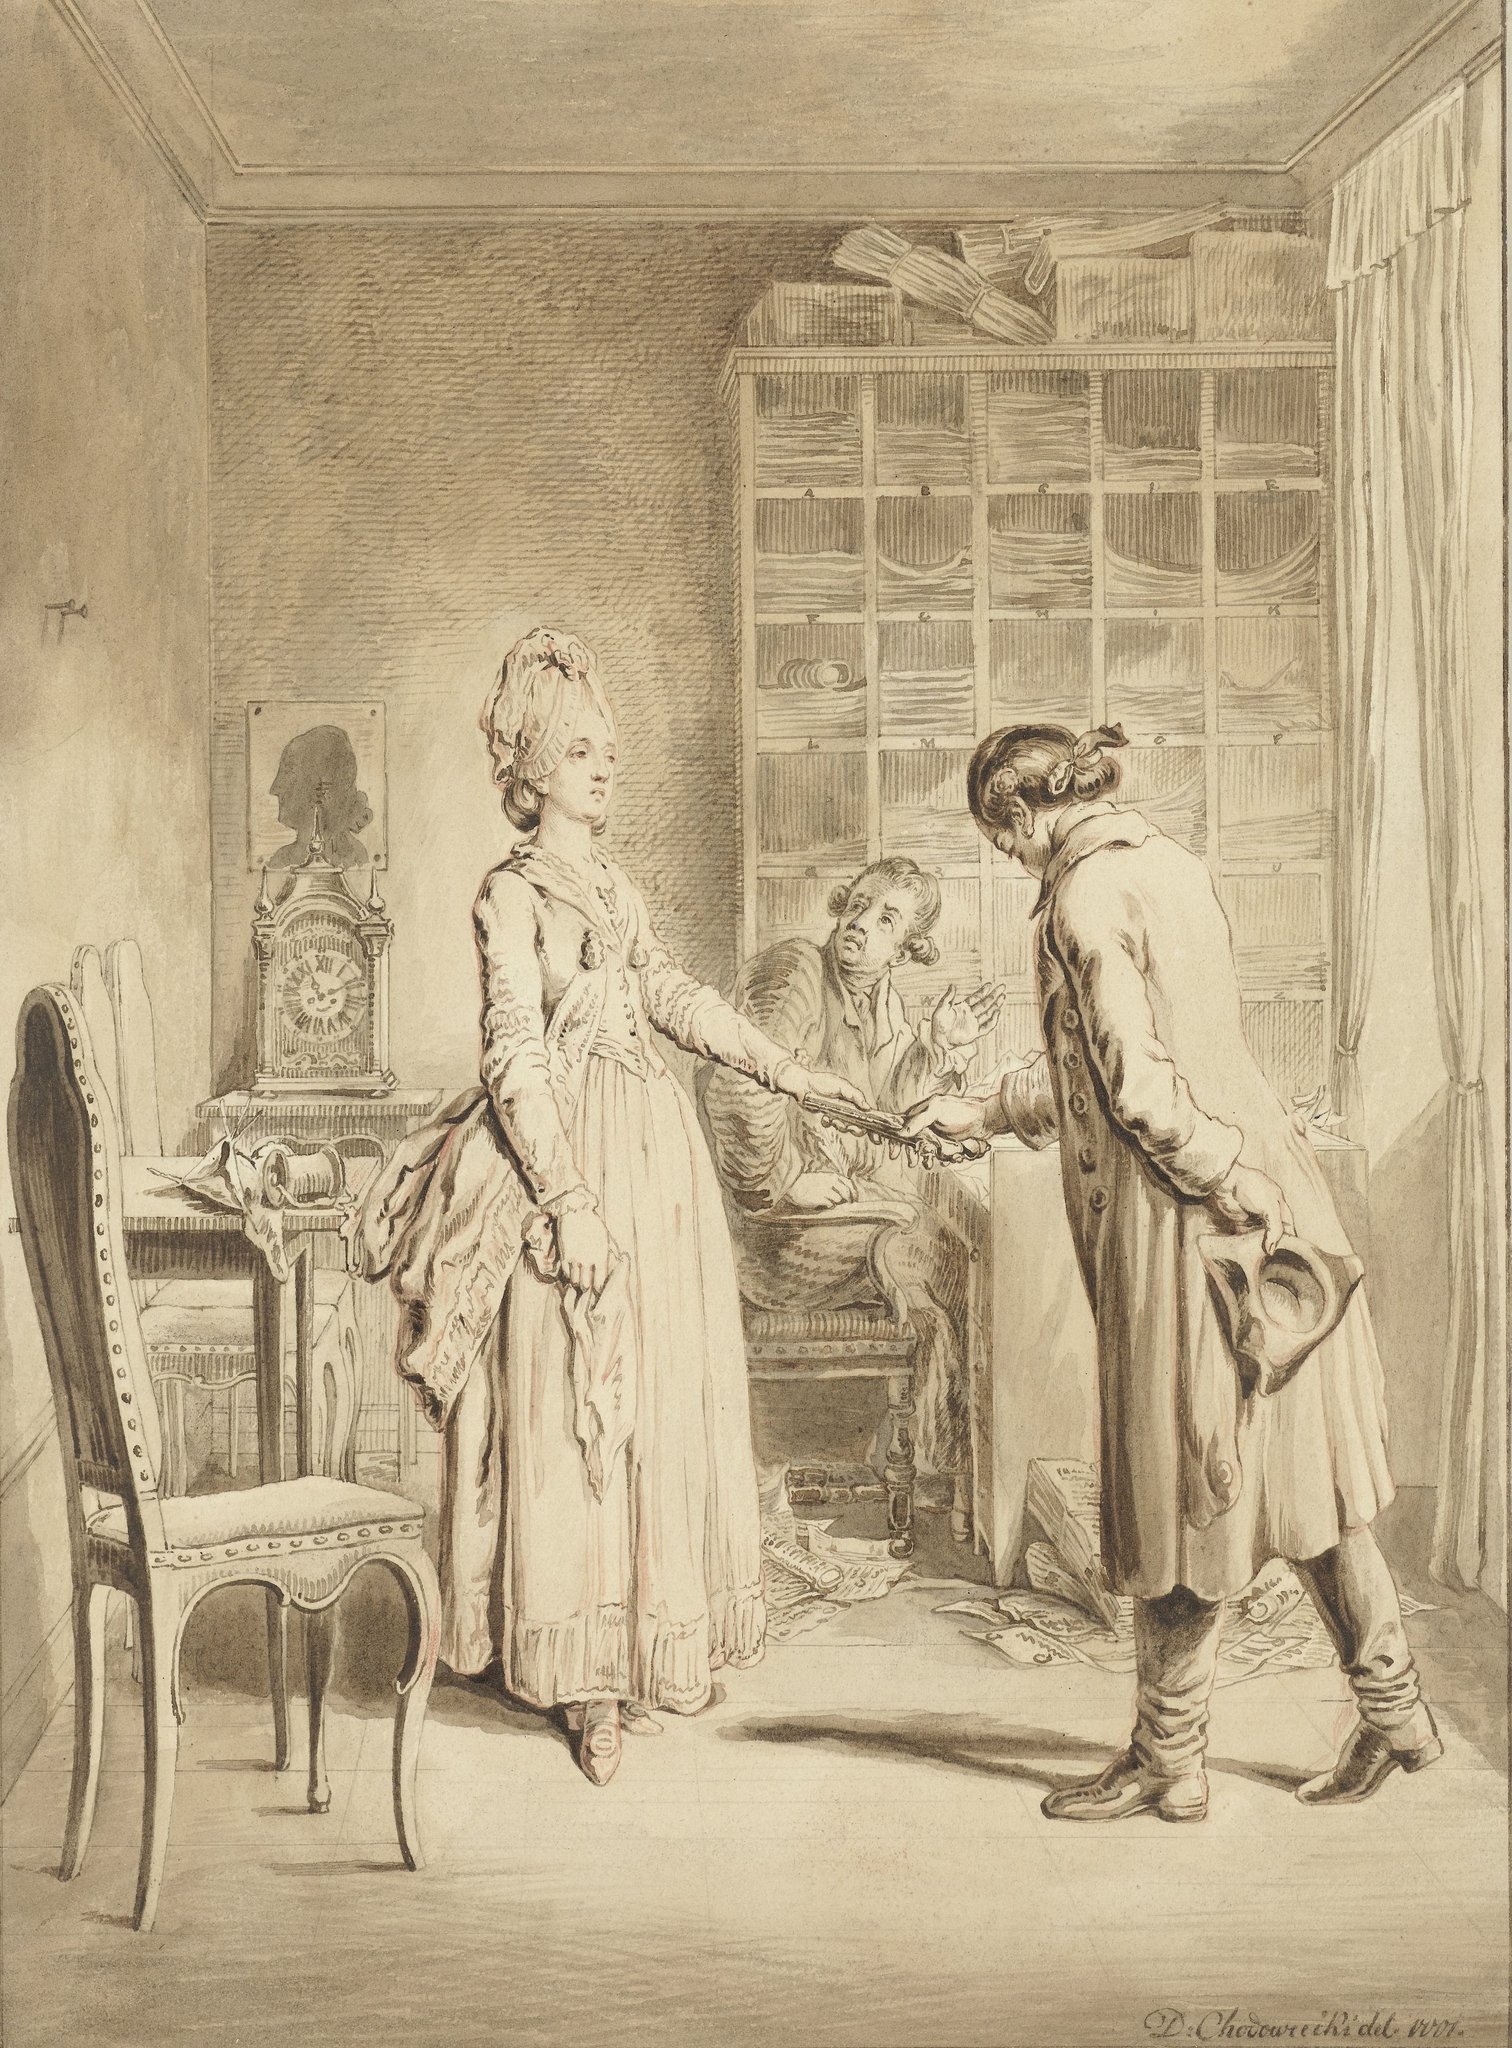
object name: drawing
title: Lotte overhandigt pistolen aan Werthers bediende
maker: daniel nikolaus chodowiecki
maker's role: draughtsman, print maker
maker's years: 1726-1801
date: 1777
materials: ink, paper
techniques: brush, pen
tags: (scenes from) specific works of literature: goethe, werther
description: Lotte overhandigt aan Werthers bediende de pistolen waarmee zijn meester een einde aan zijn leven zal maken. Op de achtergrond Lotte's echtgenoot Albert. Scène uit Goethe's Die Leiden des jungen Werthers.